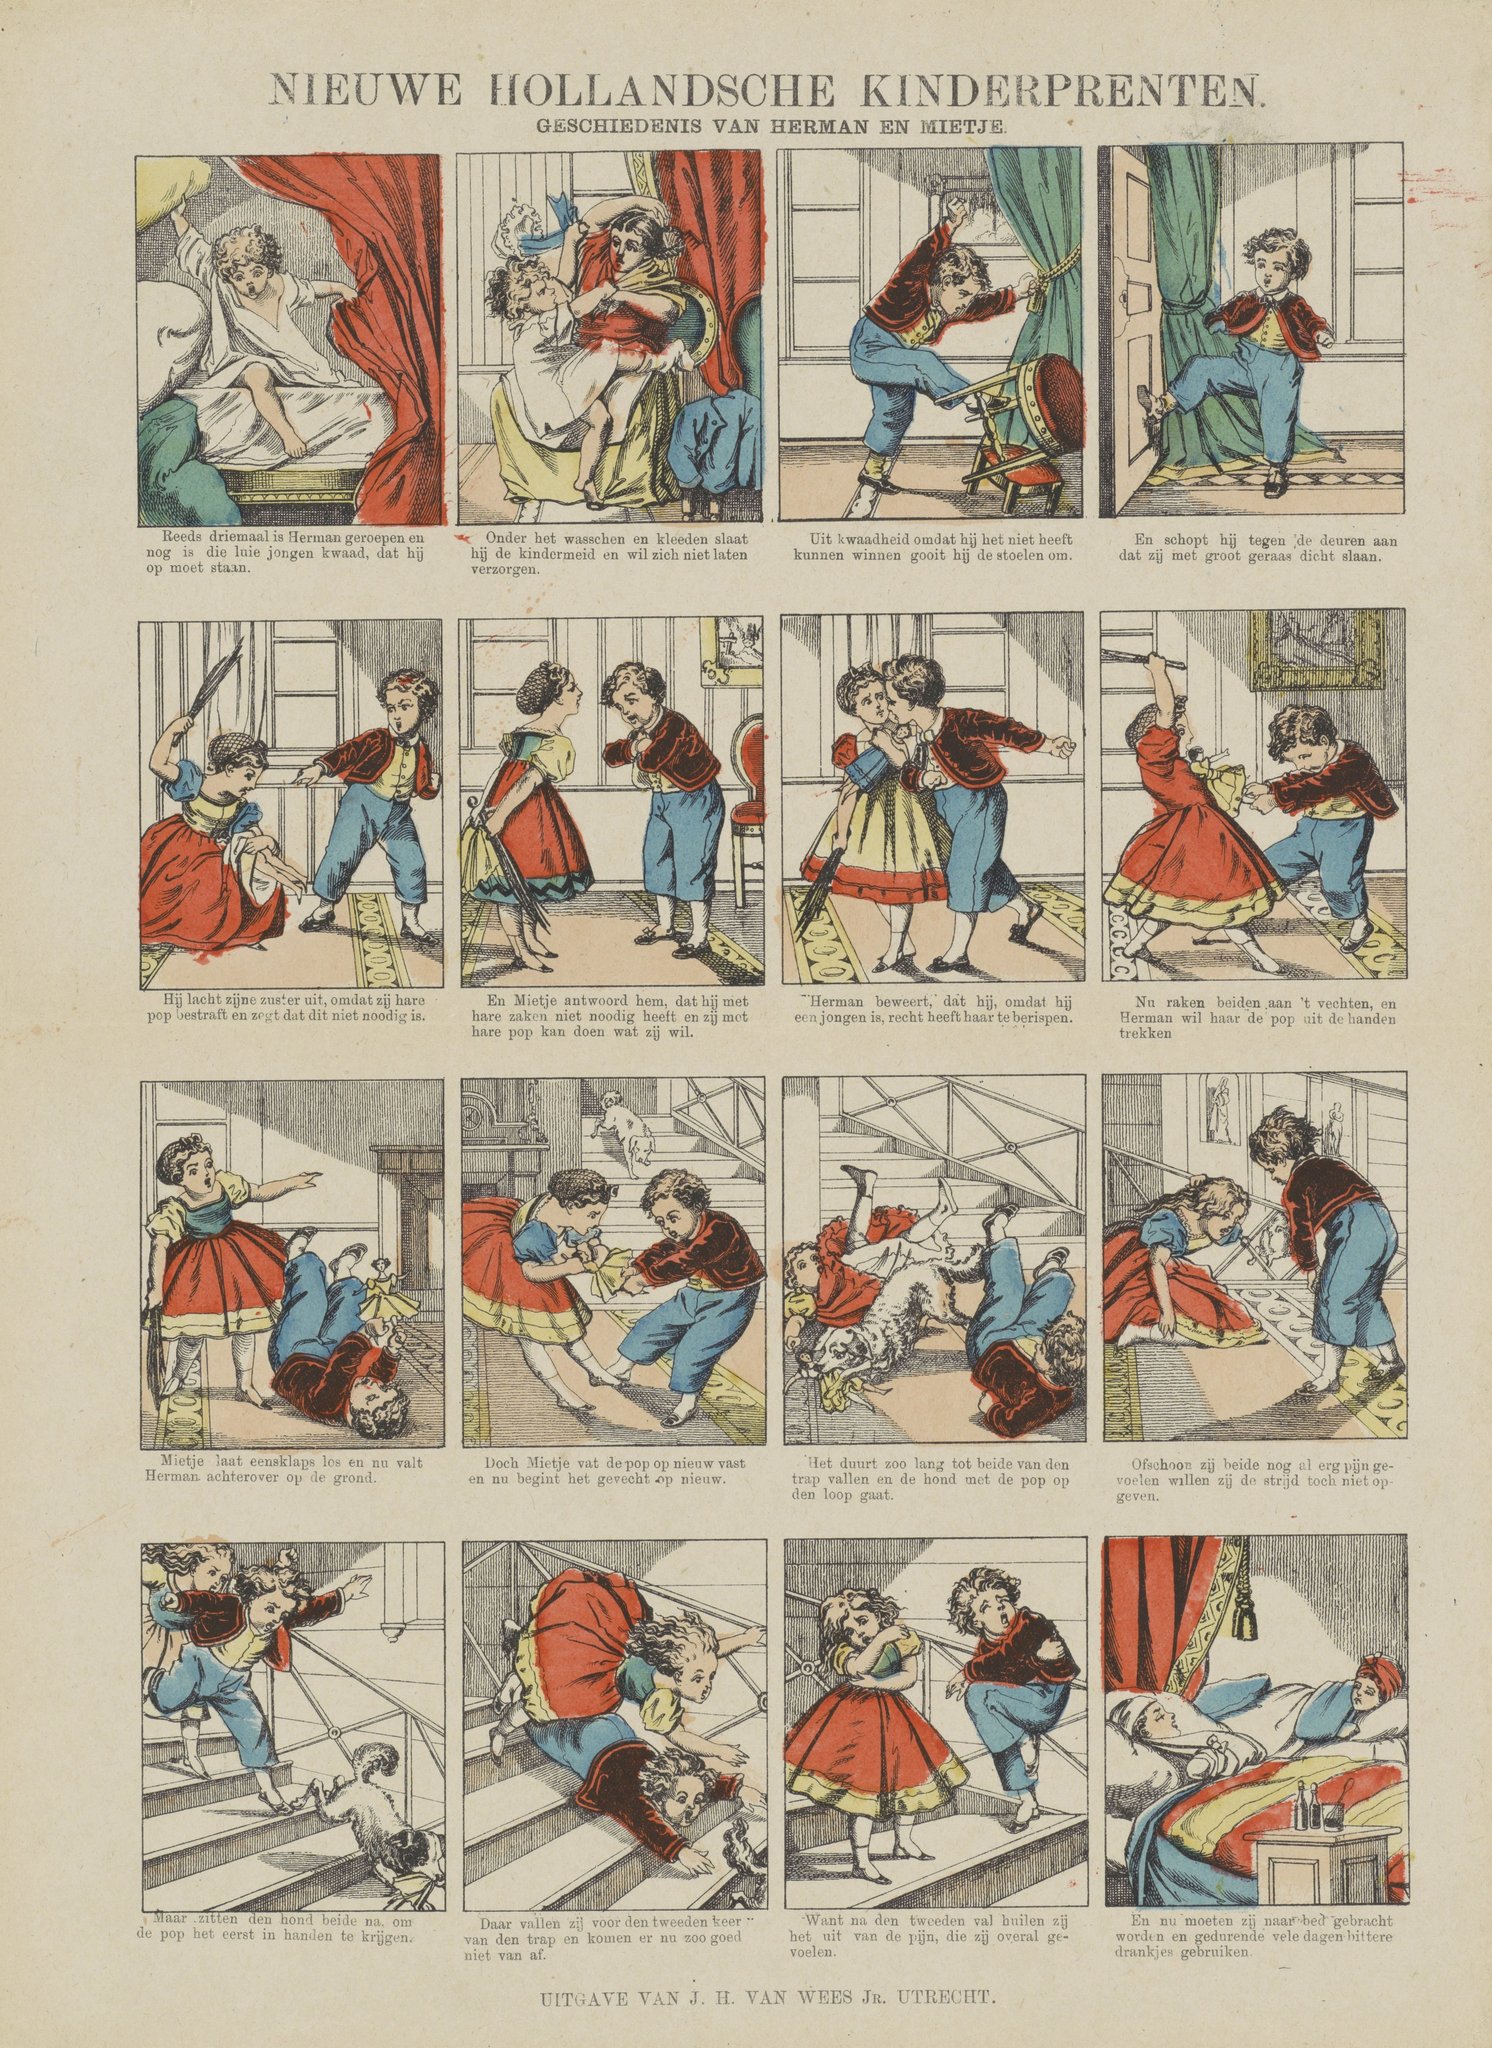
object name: print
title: Geschiedenis van Herman en Mietje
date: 1869-1888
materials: paper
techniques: colour, letterpress printing, lithograph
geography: utrecht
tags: (playing with) dolls, quarrel, argument, brothers or sisters (second degree family relationships)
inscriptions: collector's mark: Lugt 2760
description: Blad met 16 voorstellingen van broer en zus Herman en Mietje die met elkaar vechten om een pop. Onder elke afbeelding een onderschrift.